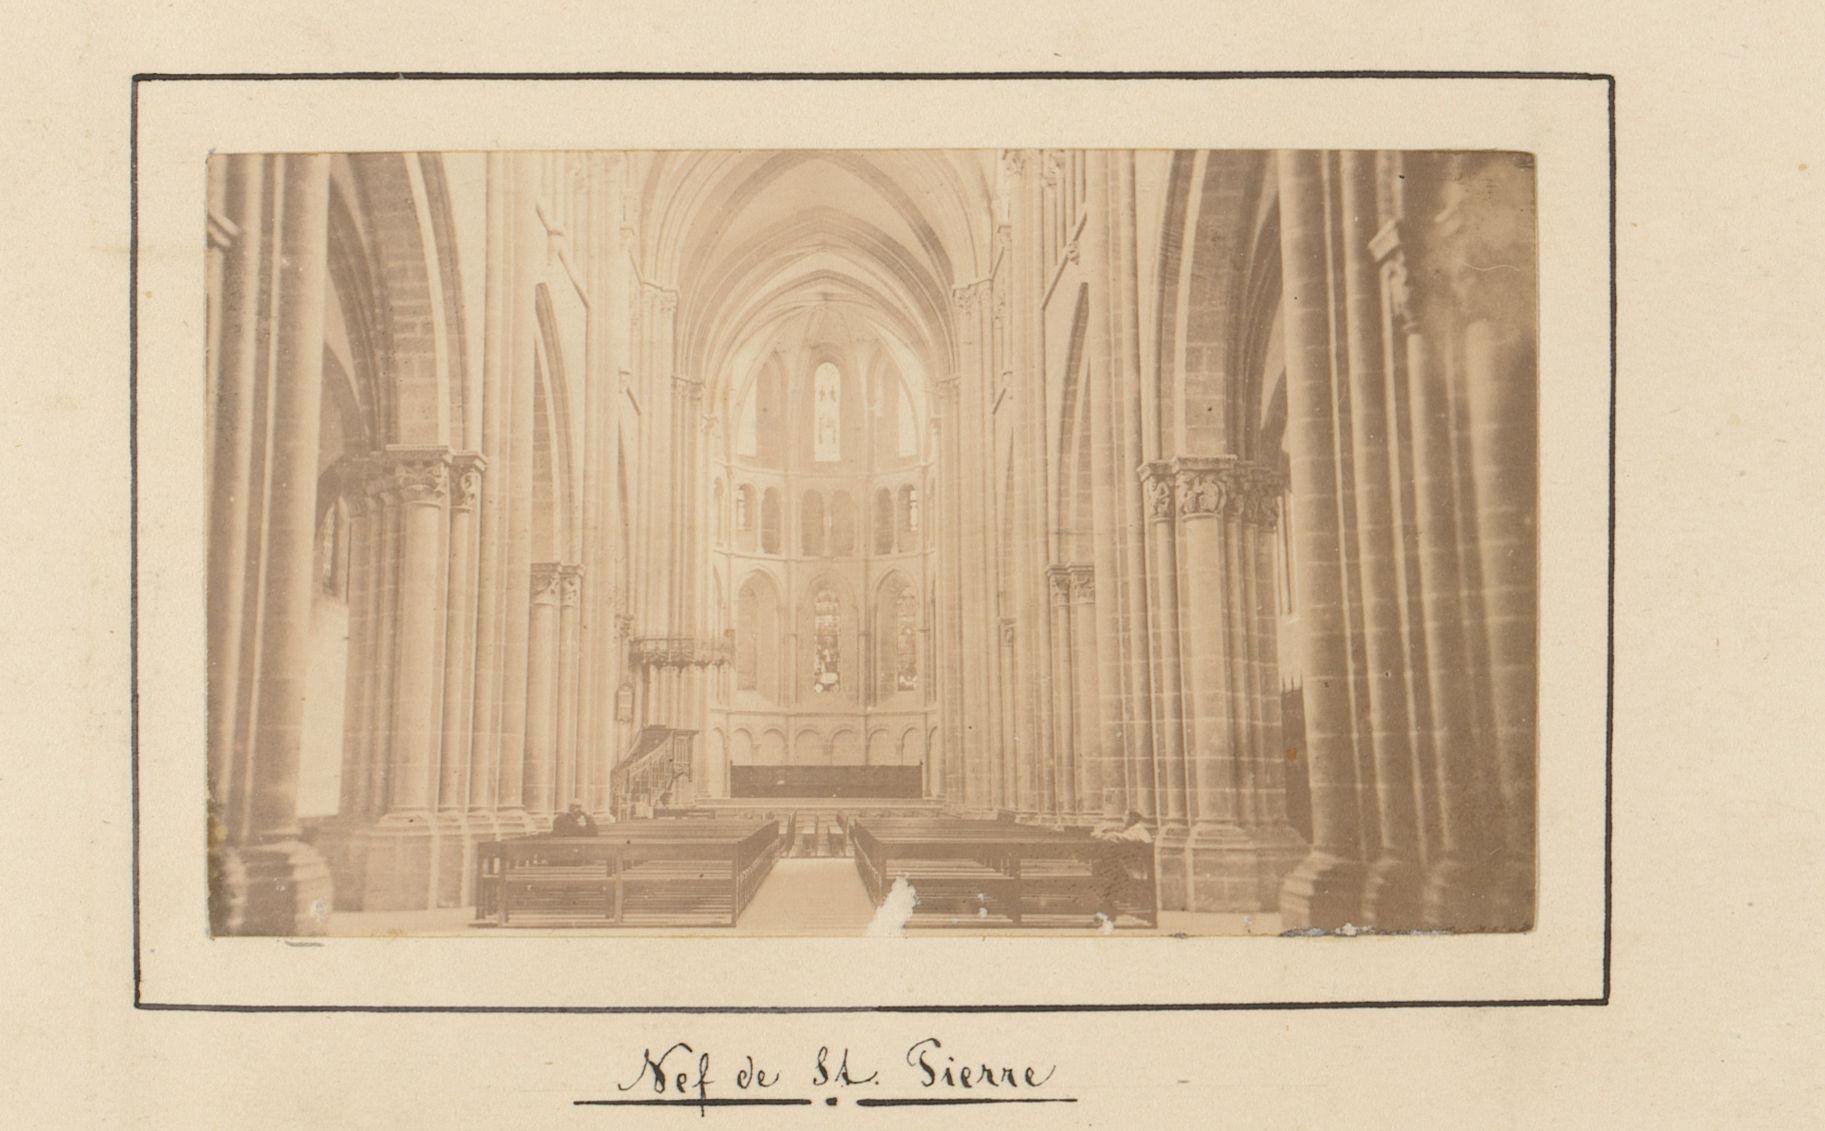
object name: album leaf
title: Nef de St. Pierre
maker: Anonymous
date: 1870-1890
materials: paper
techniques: albumen print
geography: geneva cathedral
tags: parts of church interior: nave